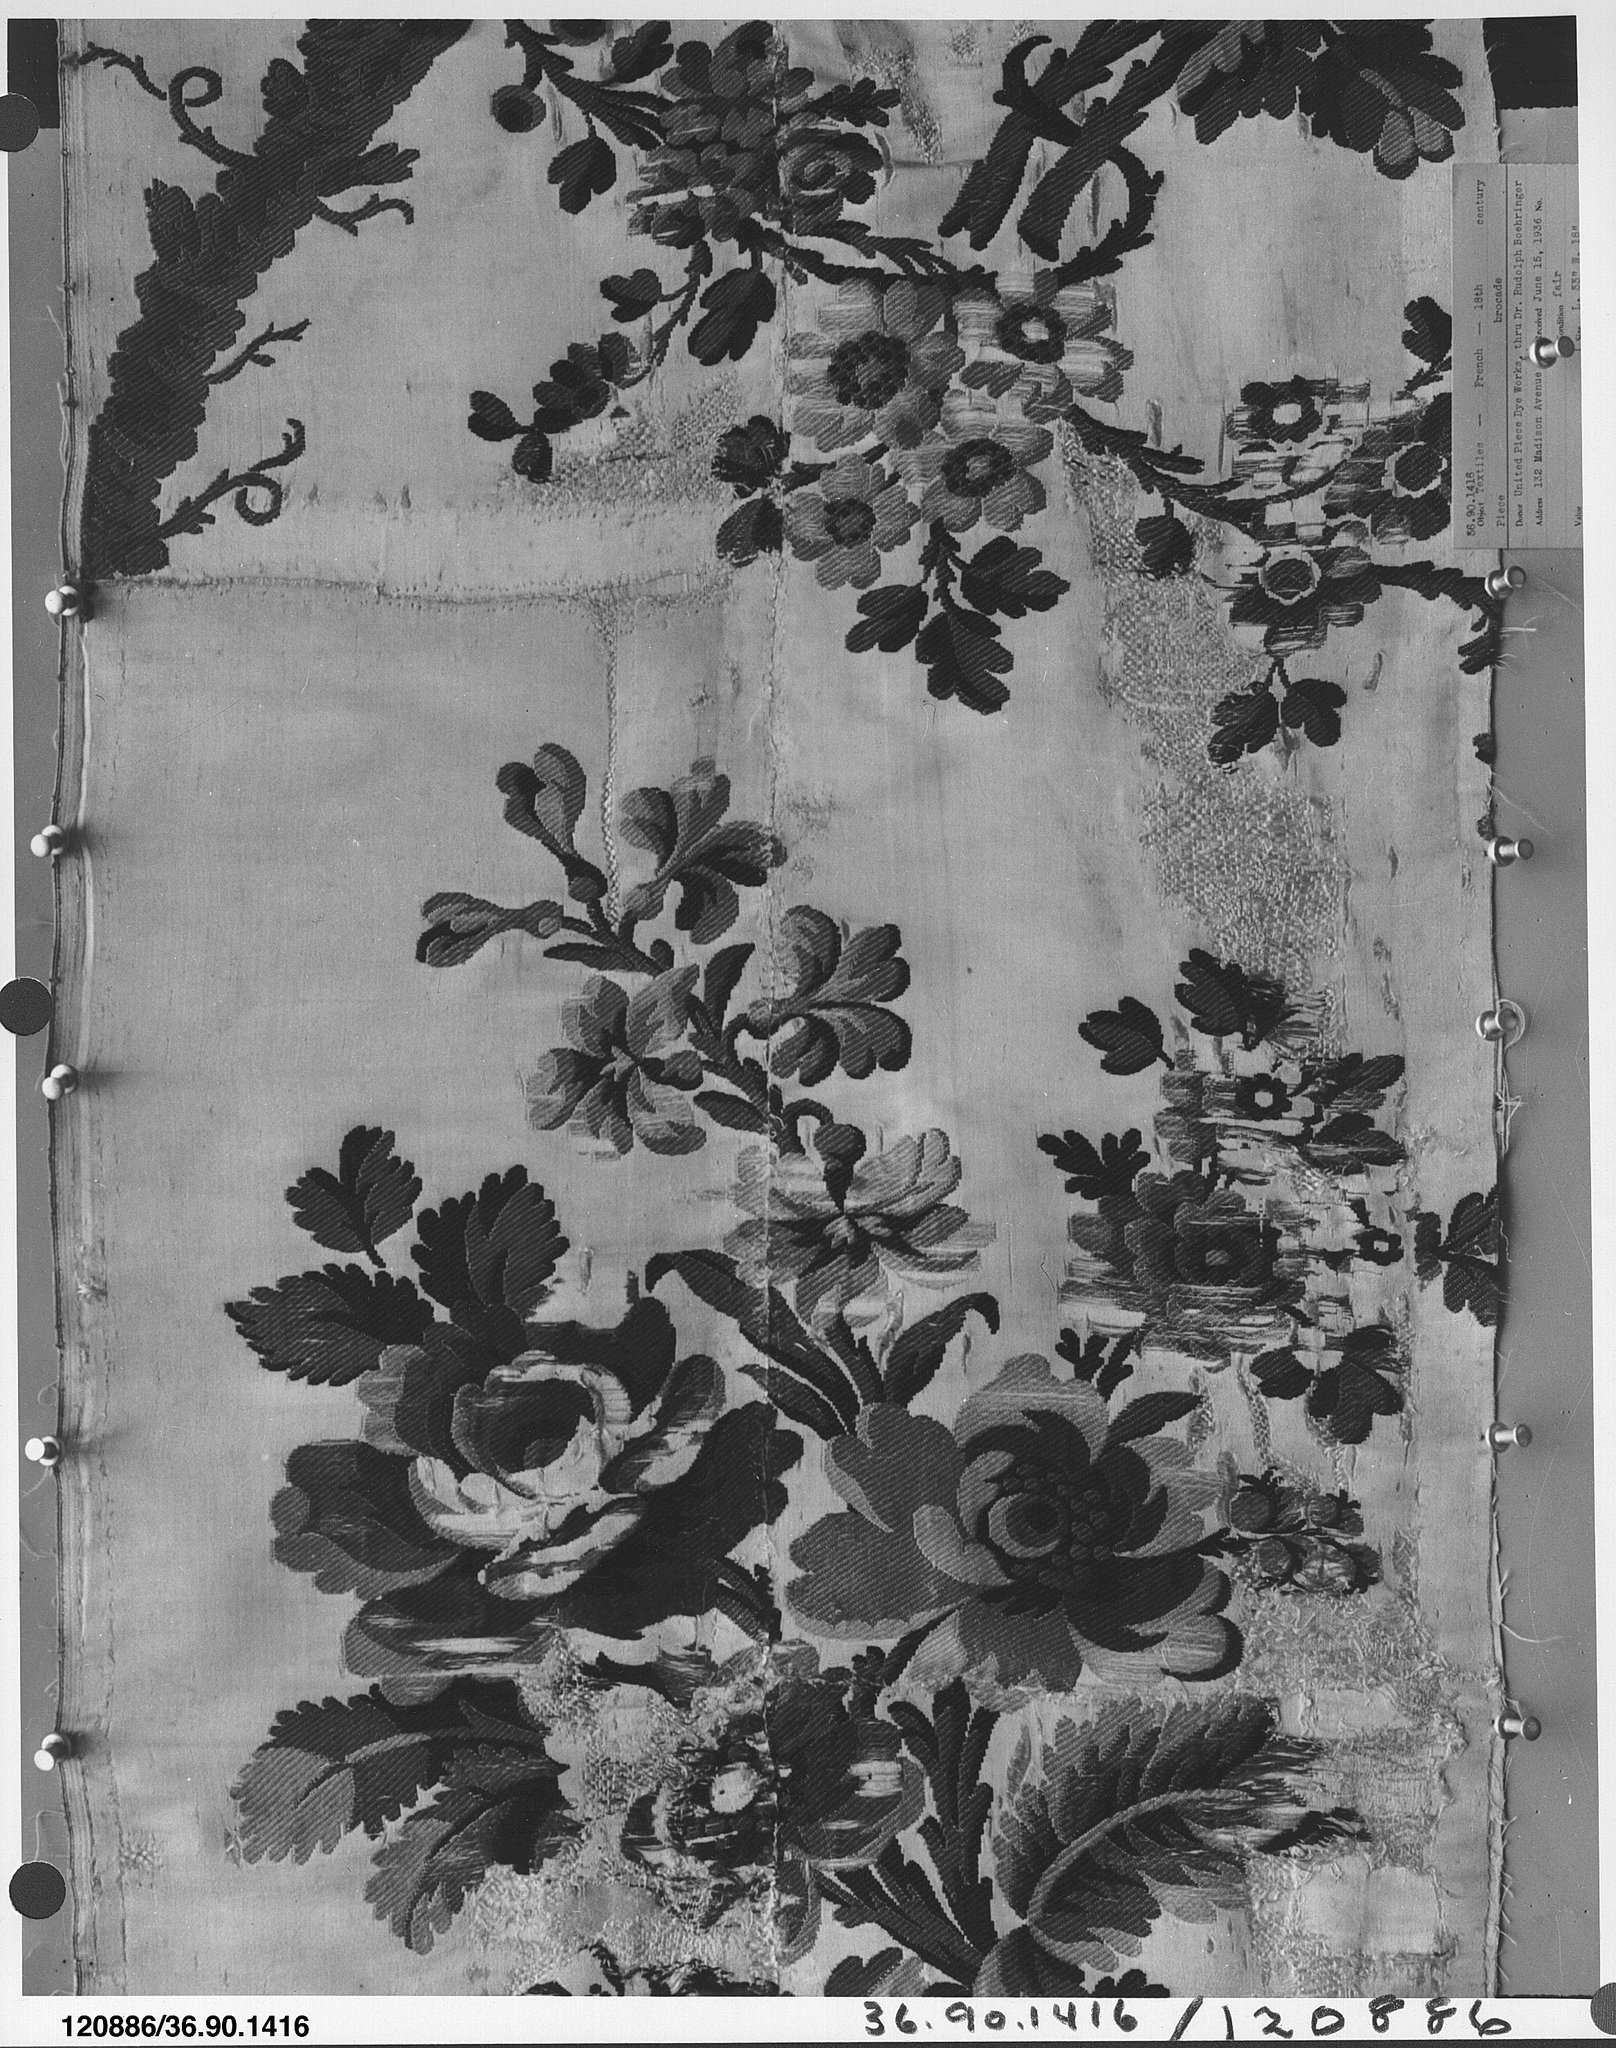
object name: piece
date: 1750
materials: silk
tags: flowers,leaves